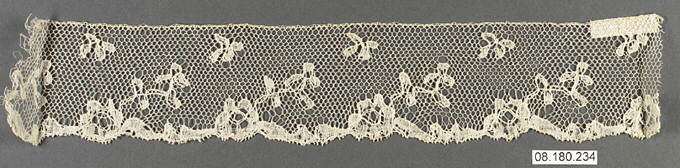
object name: piece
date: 1801-1900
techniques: lace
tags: leaves